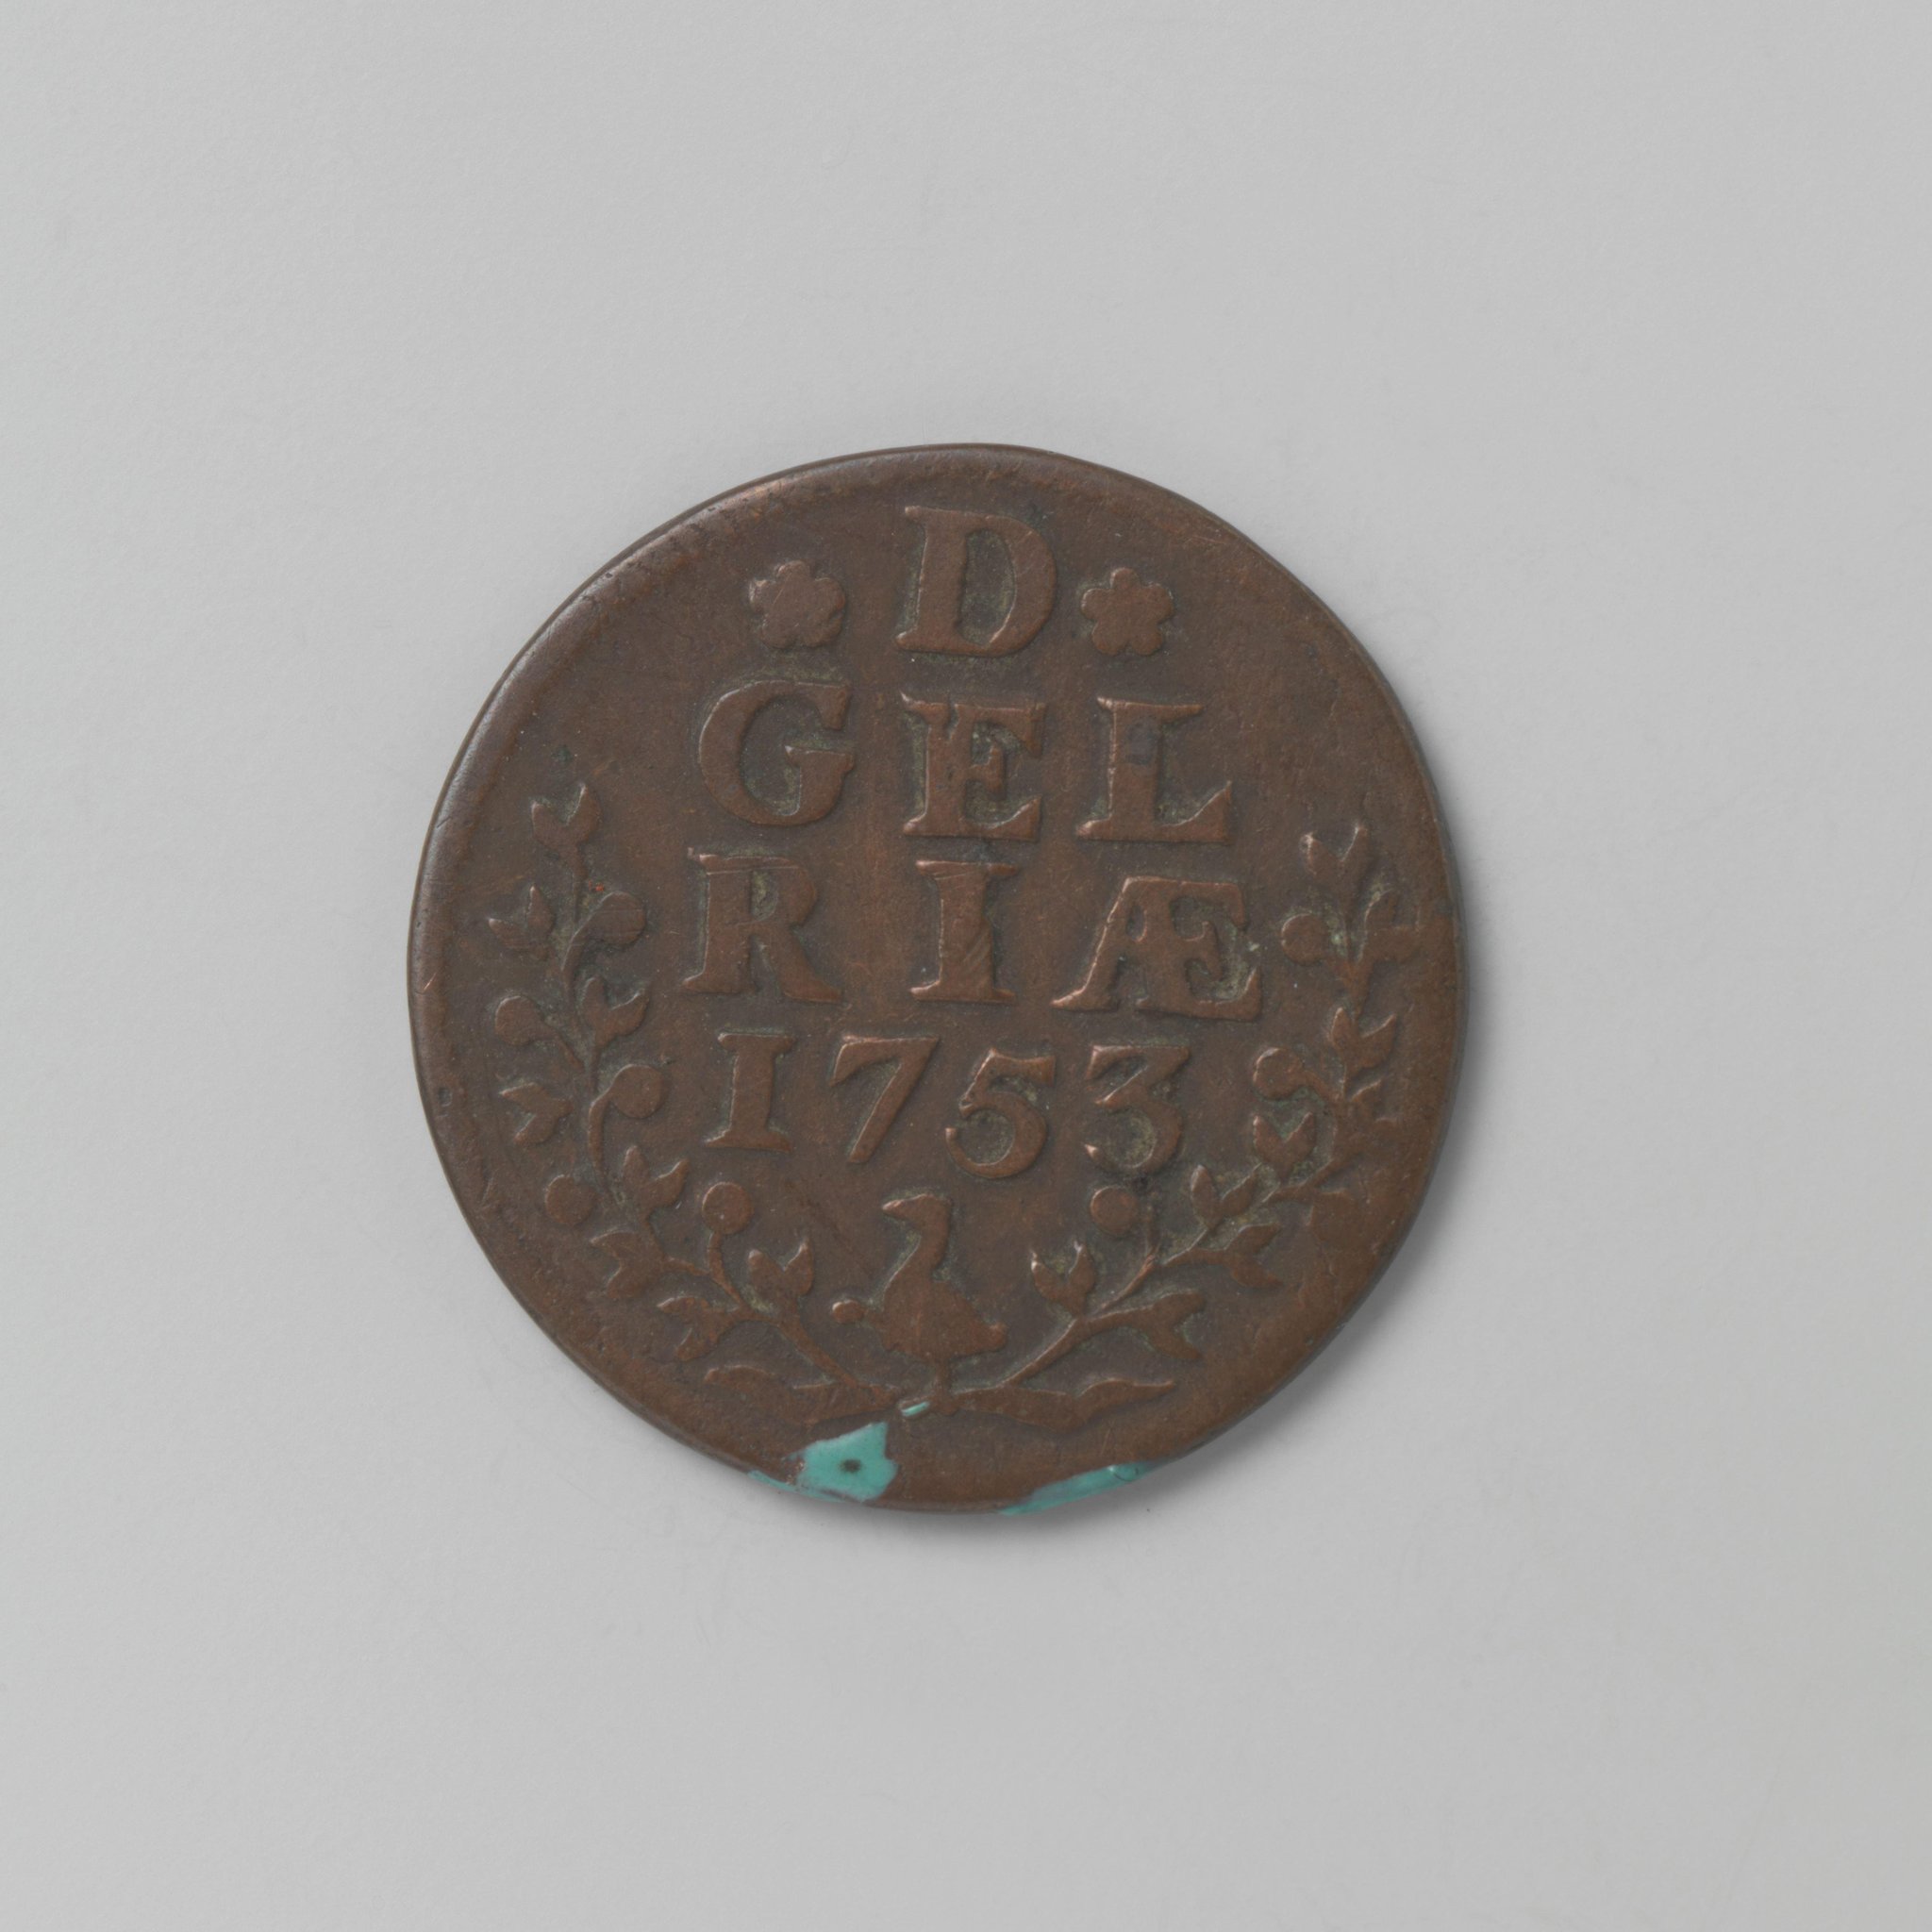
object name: coin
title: Gelderse duit, 1753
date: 1753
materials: copper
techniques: striking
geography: harderwijk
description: Koperen munt. Voorzijde: binnen versiering in drie regels D/GEL/RIAE, daaronder jaartal en muntmeesterteken. Keerzijde: gekroond Gelders wapenschild.